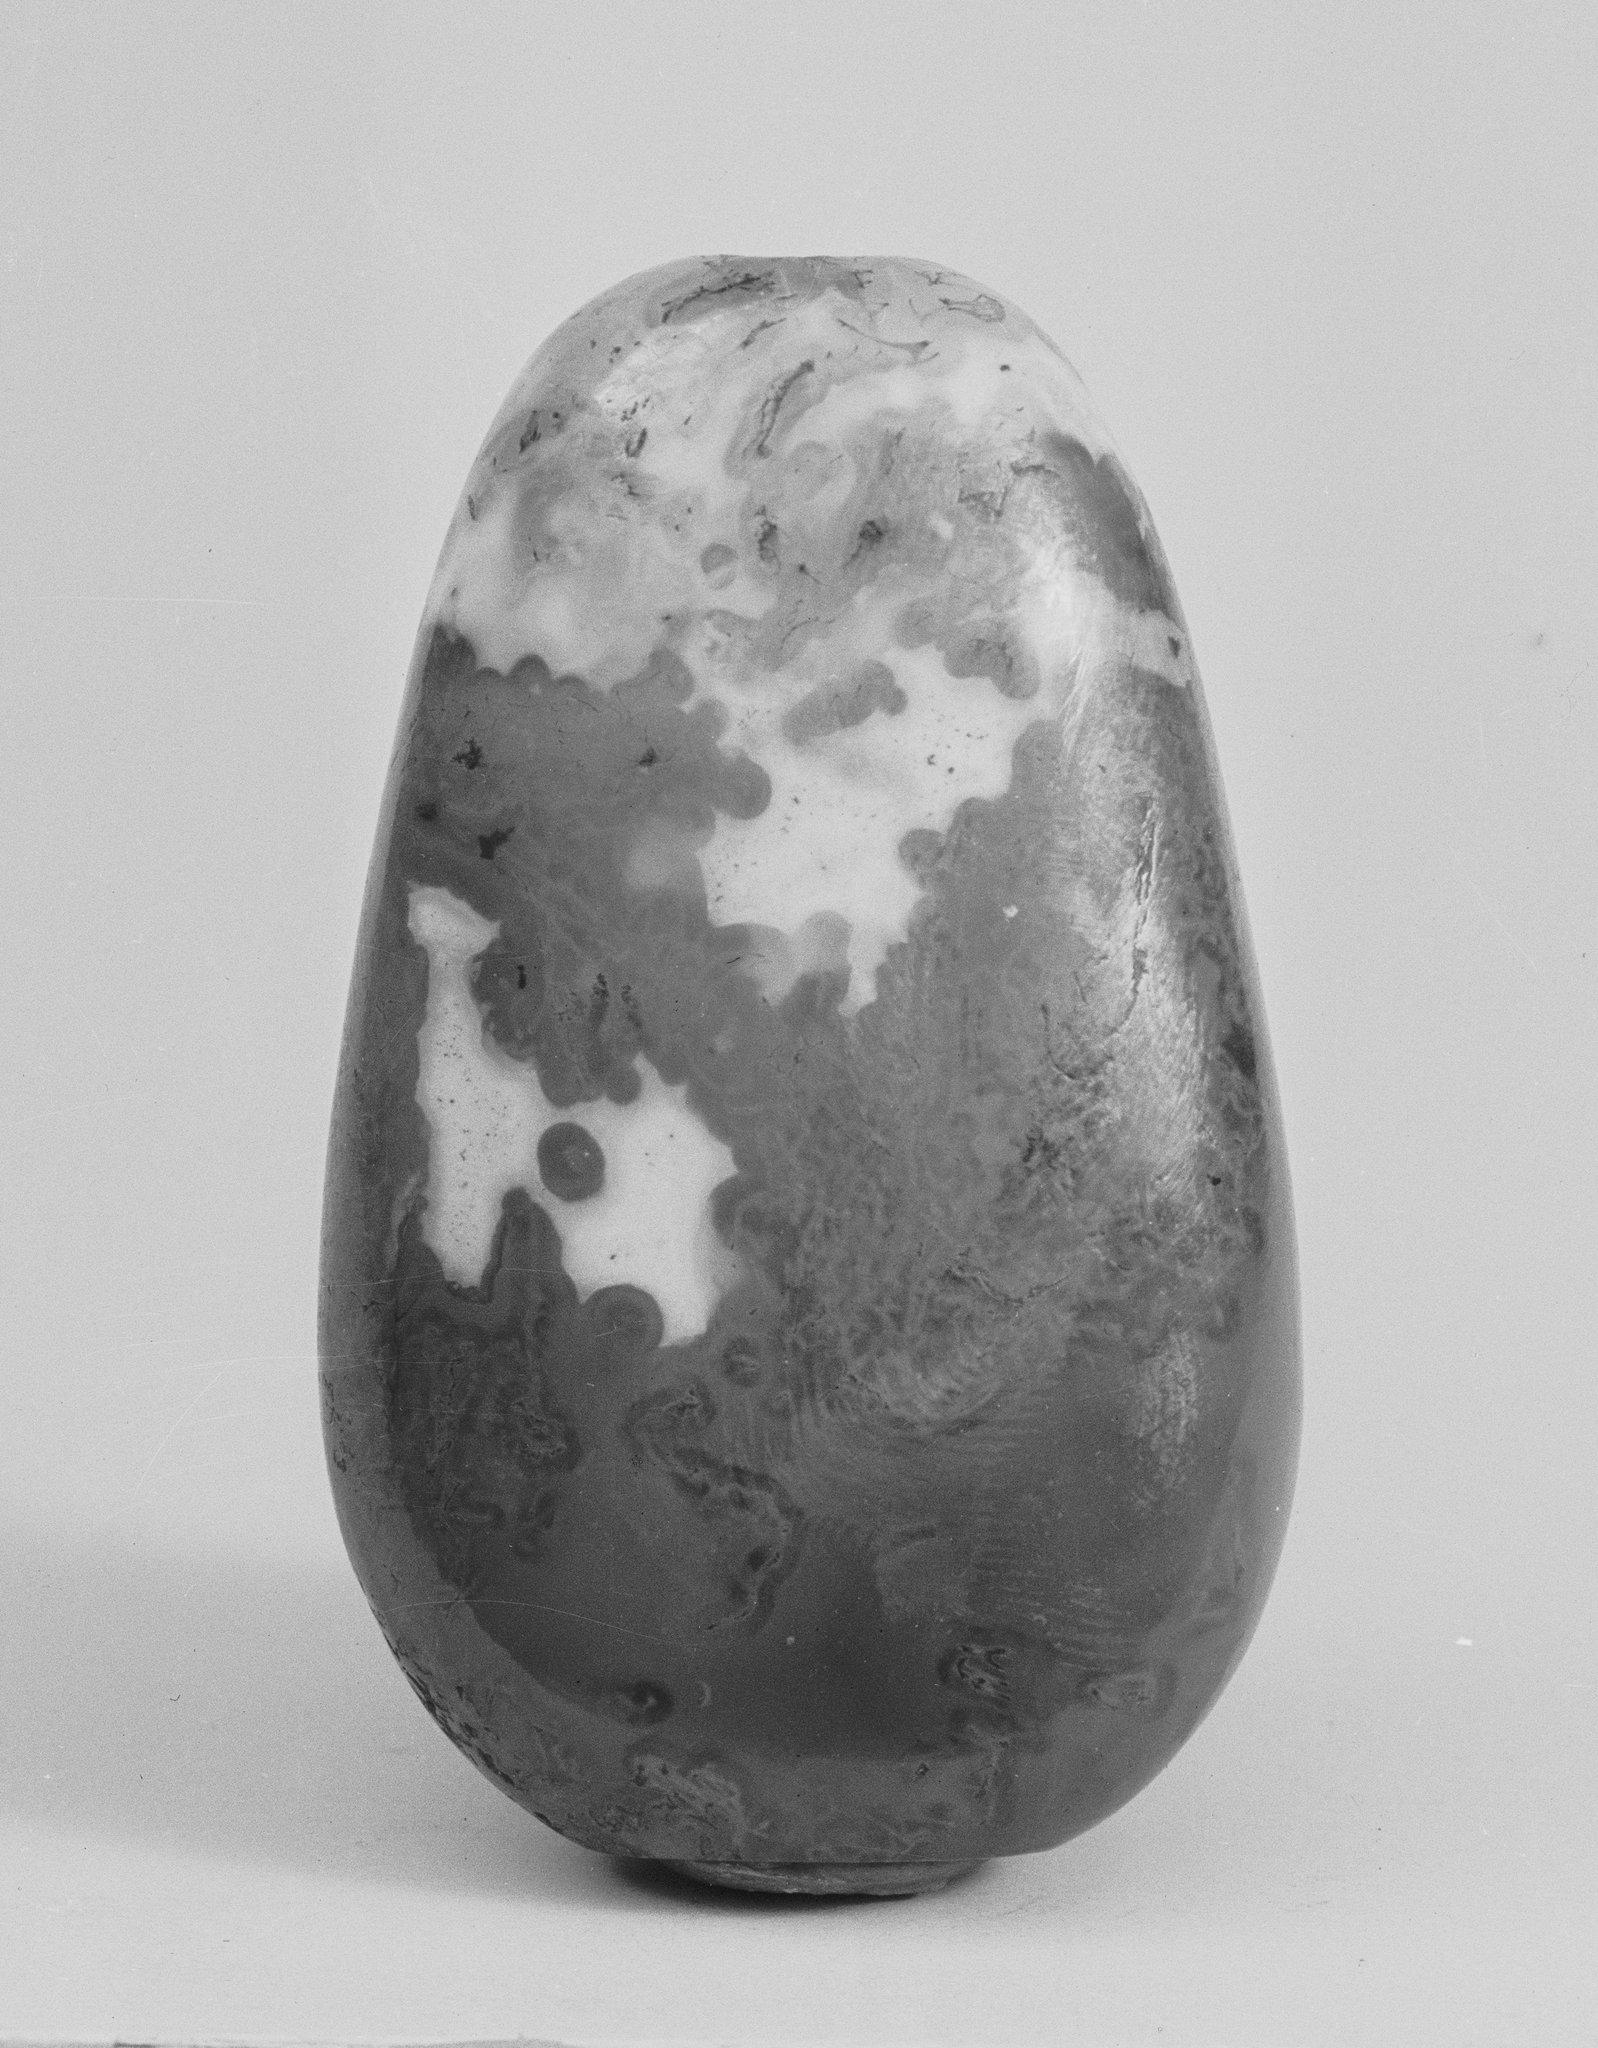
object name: snuff bottle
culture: chinese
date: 1701-1900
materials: stone